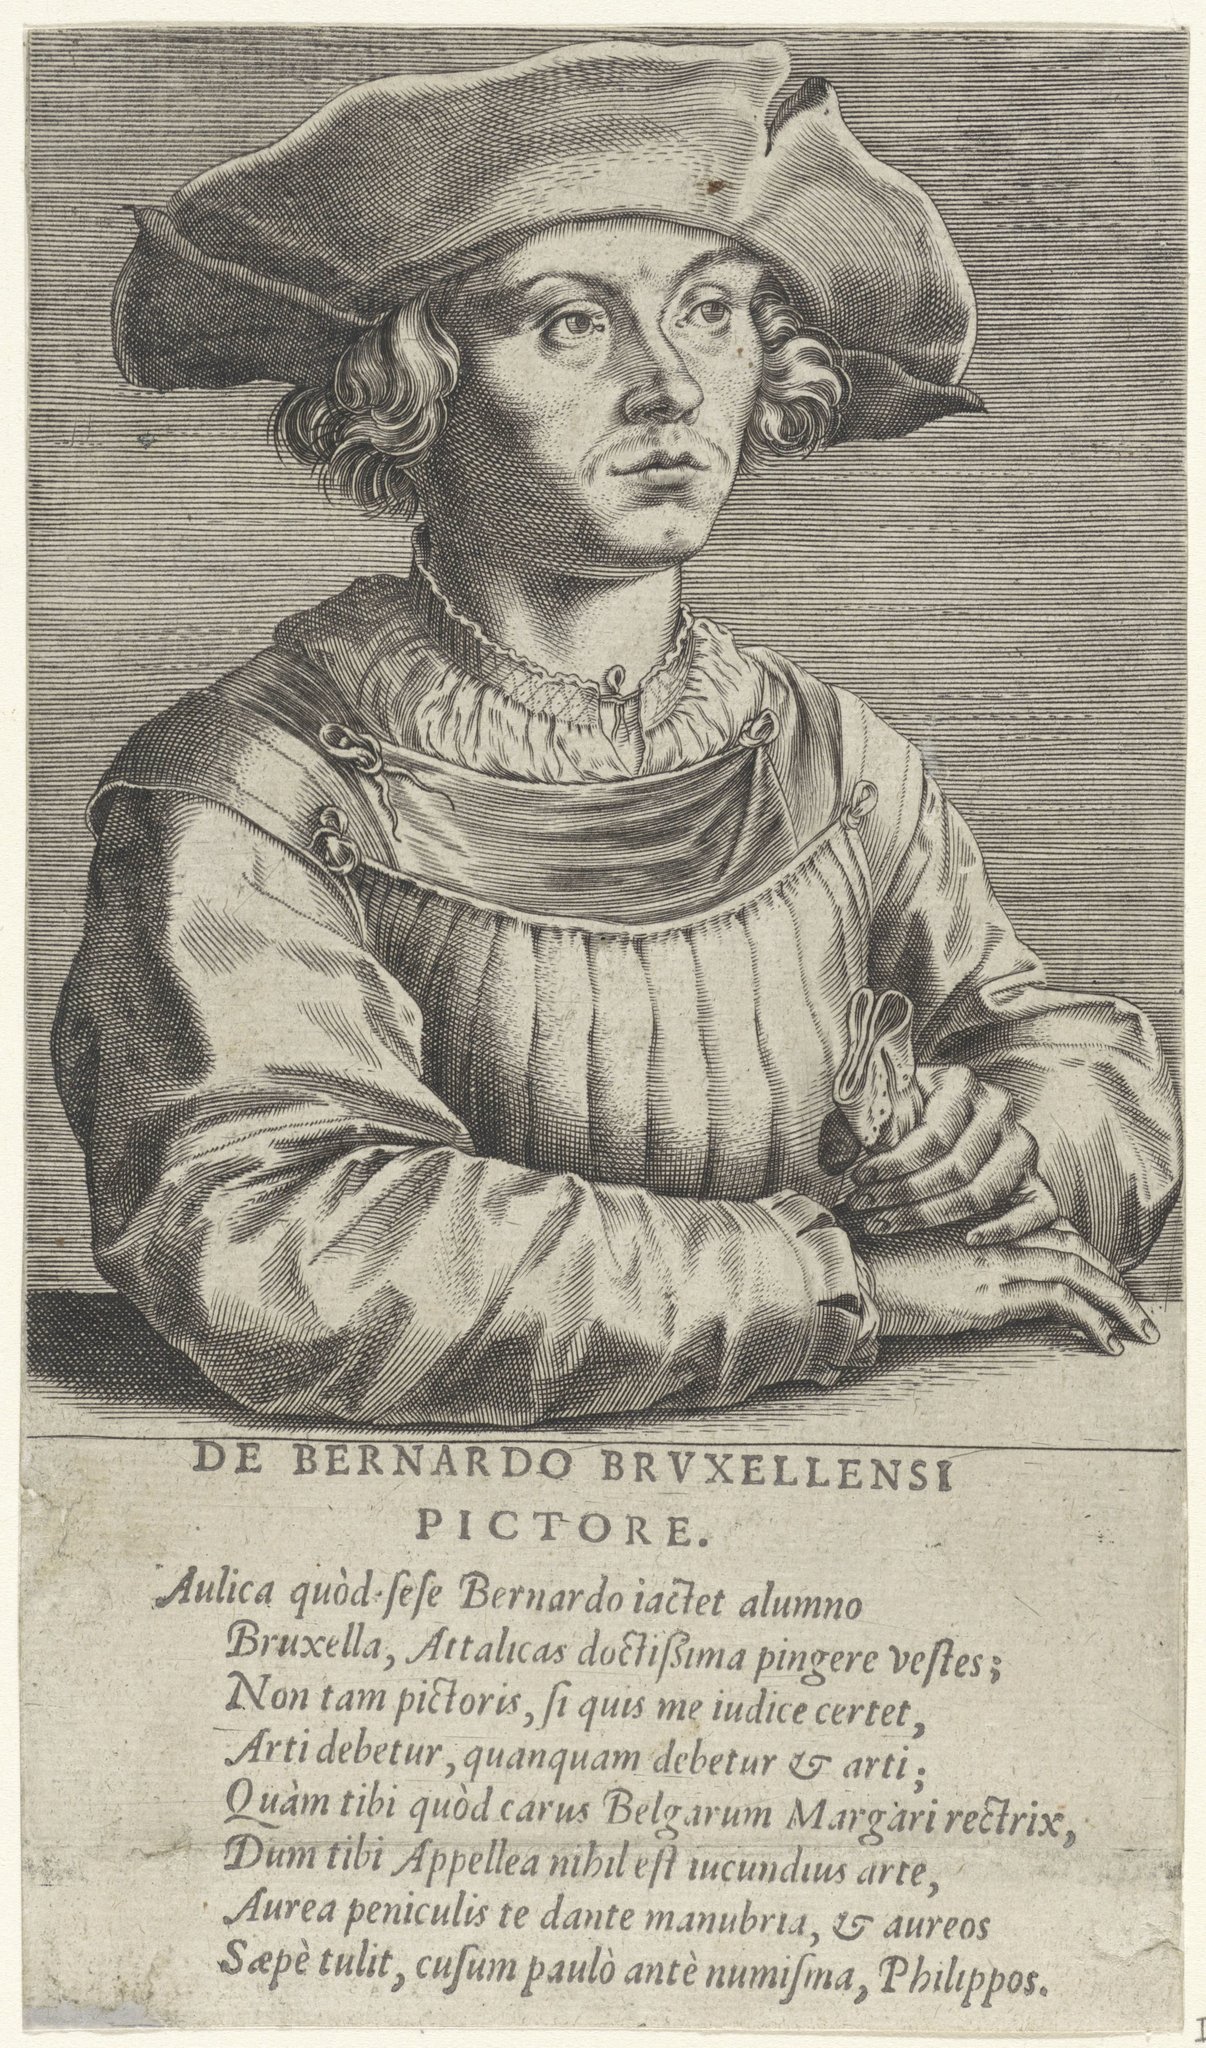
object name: print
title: Portret van de schilder Bernard van Orley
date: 1572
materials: paper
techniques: engraving, letterpress printing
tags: brussels, painter, draughtsman, bernard van orley, portrait, self-portrait of painter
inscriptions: collector's mark: Lugt 2165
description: In de marge een achtregelig onderschrift in het Latijn.